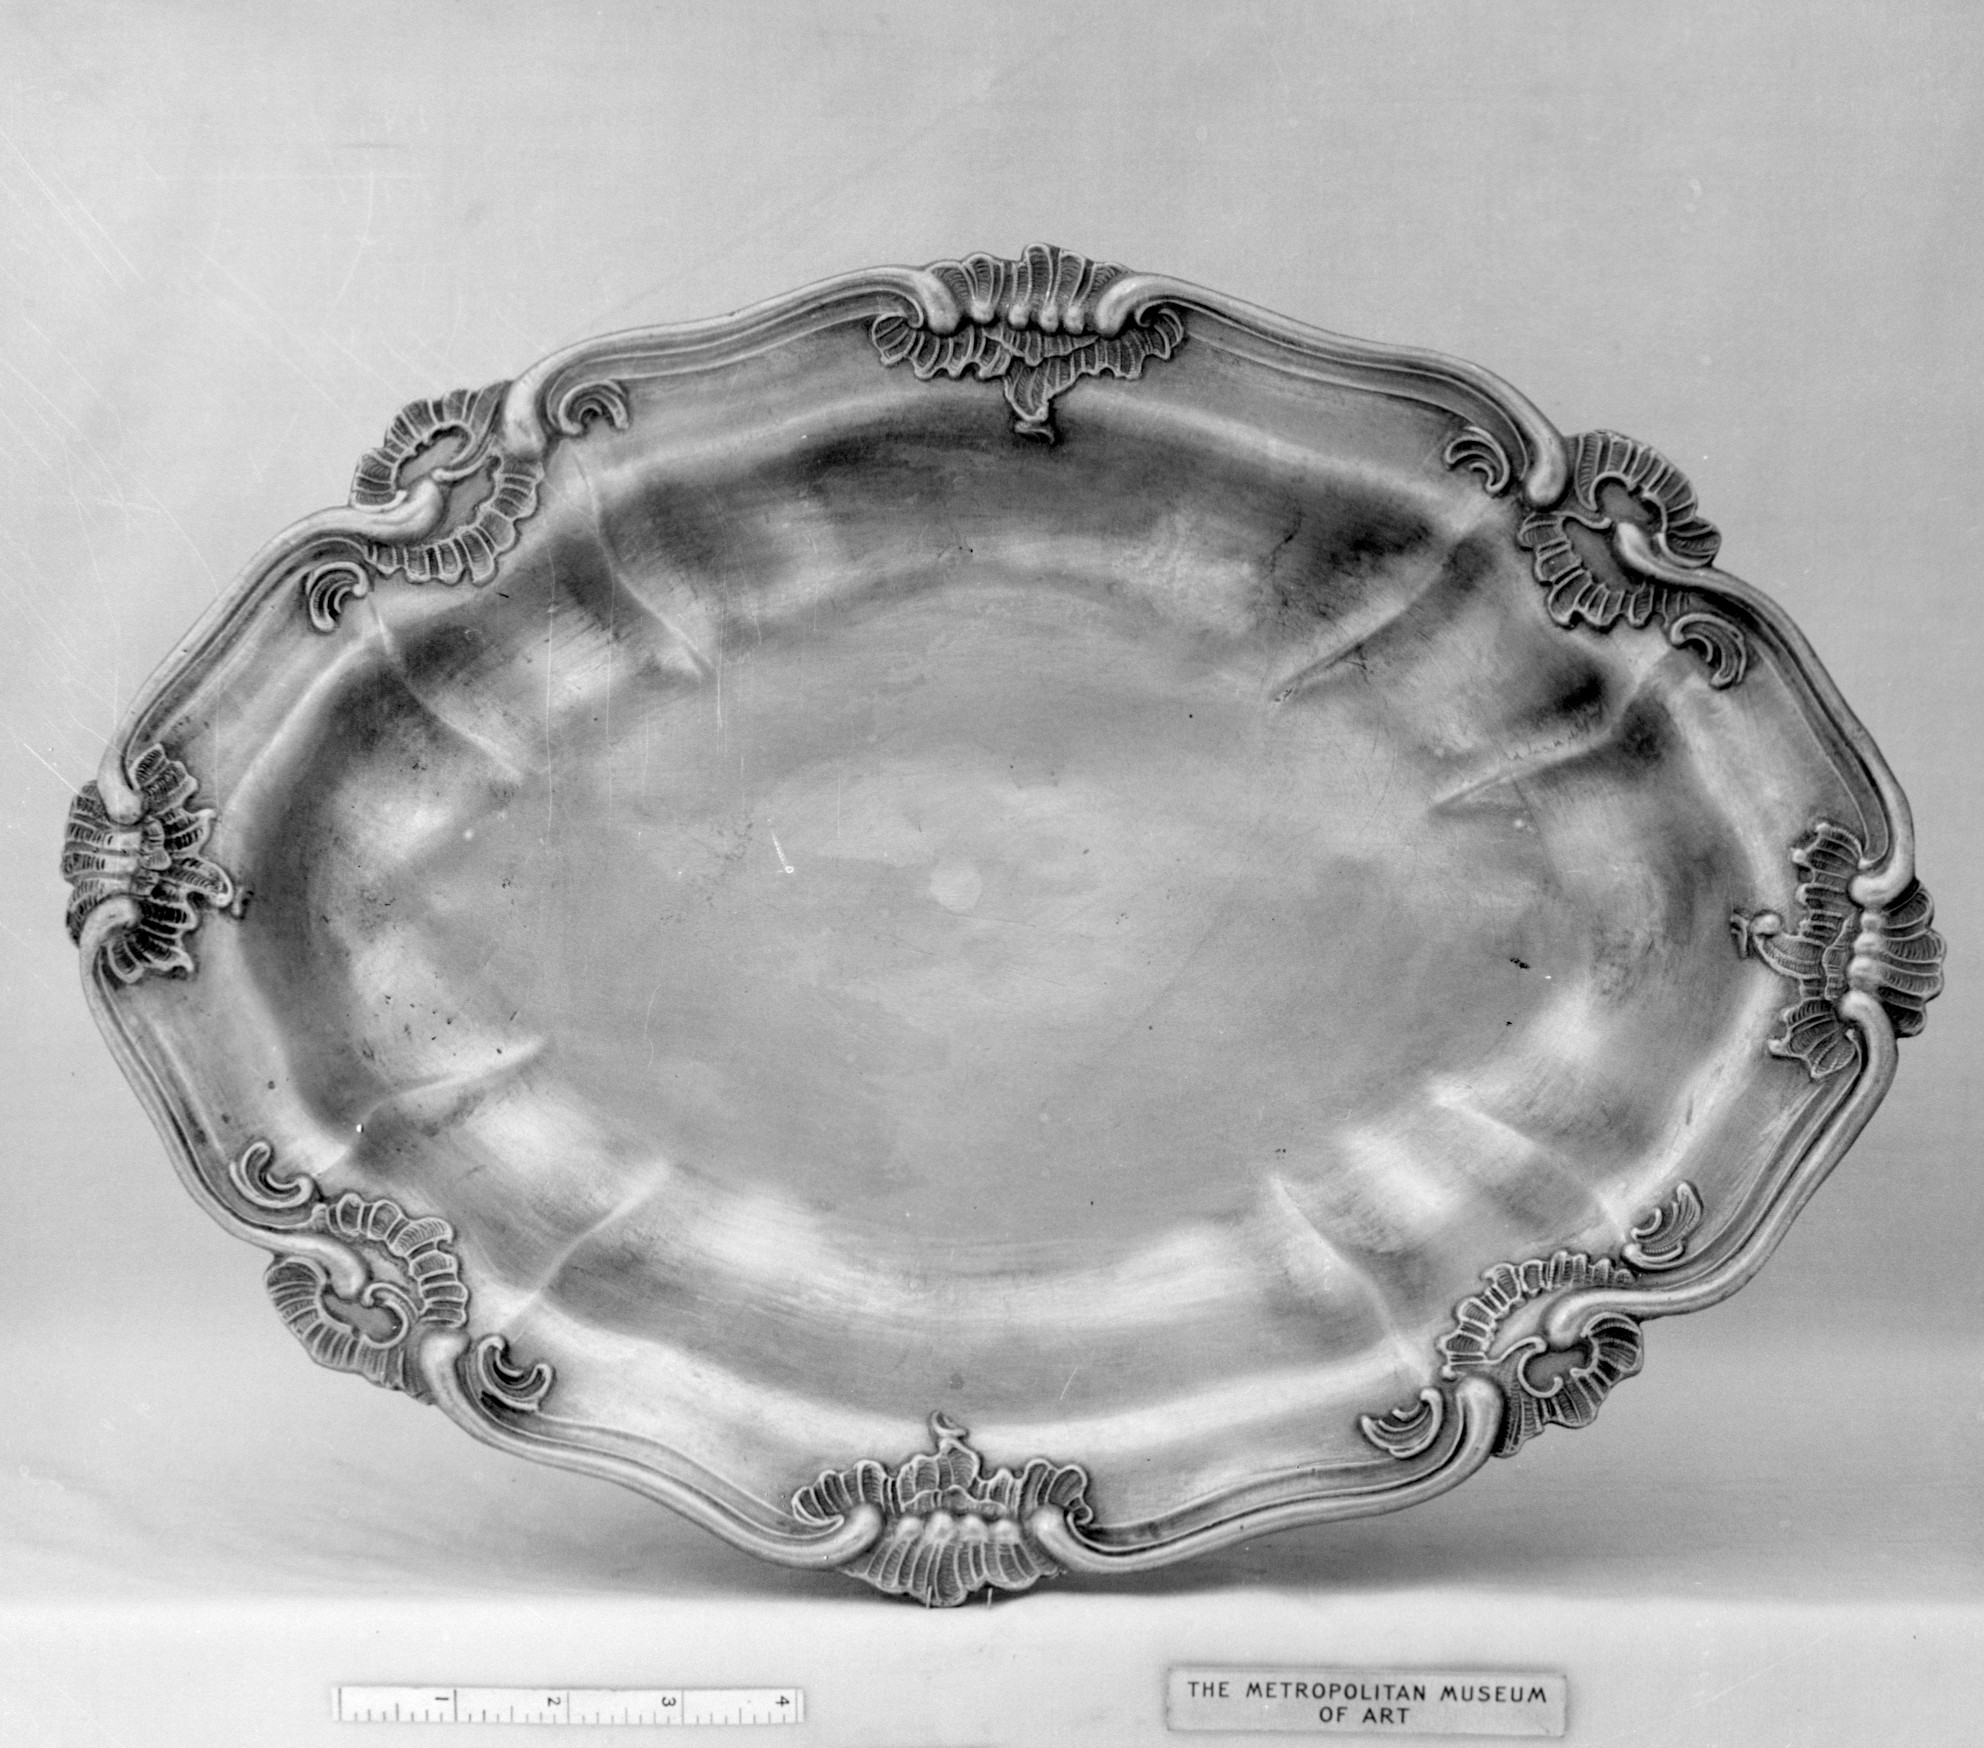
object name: dish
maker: gallus david apeller the younger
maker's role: maker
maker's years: 1769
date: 1751-1775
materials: pewter